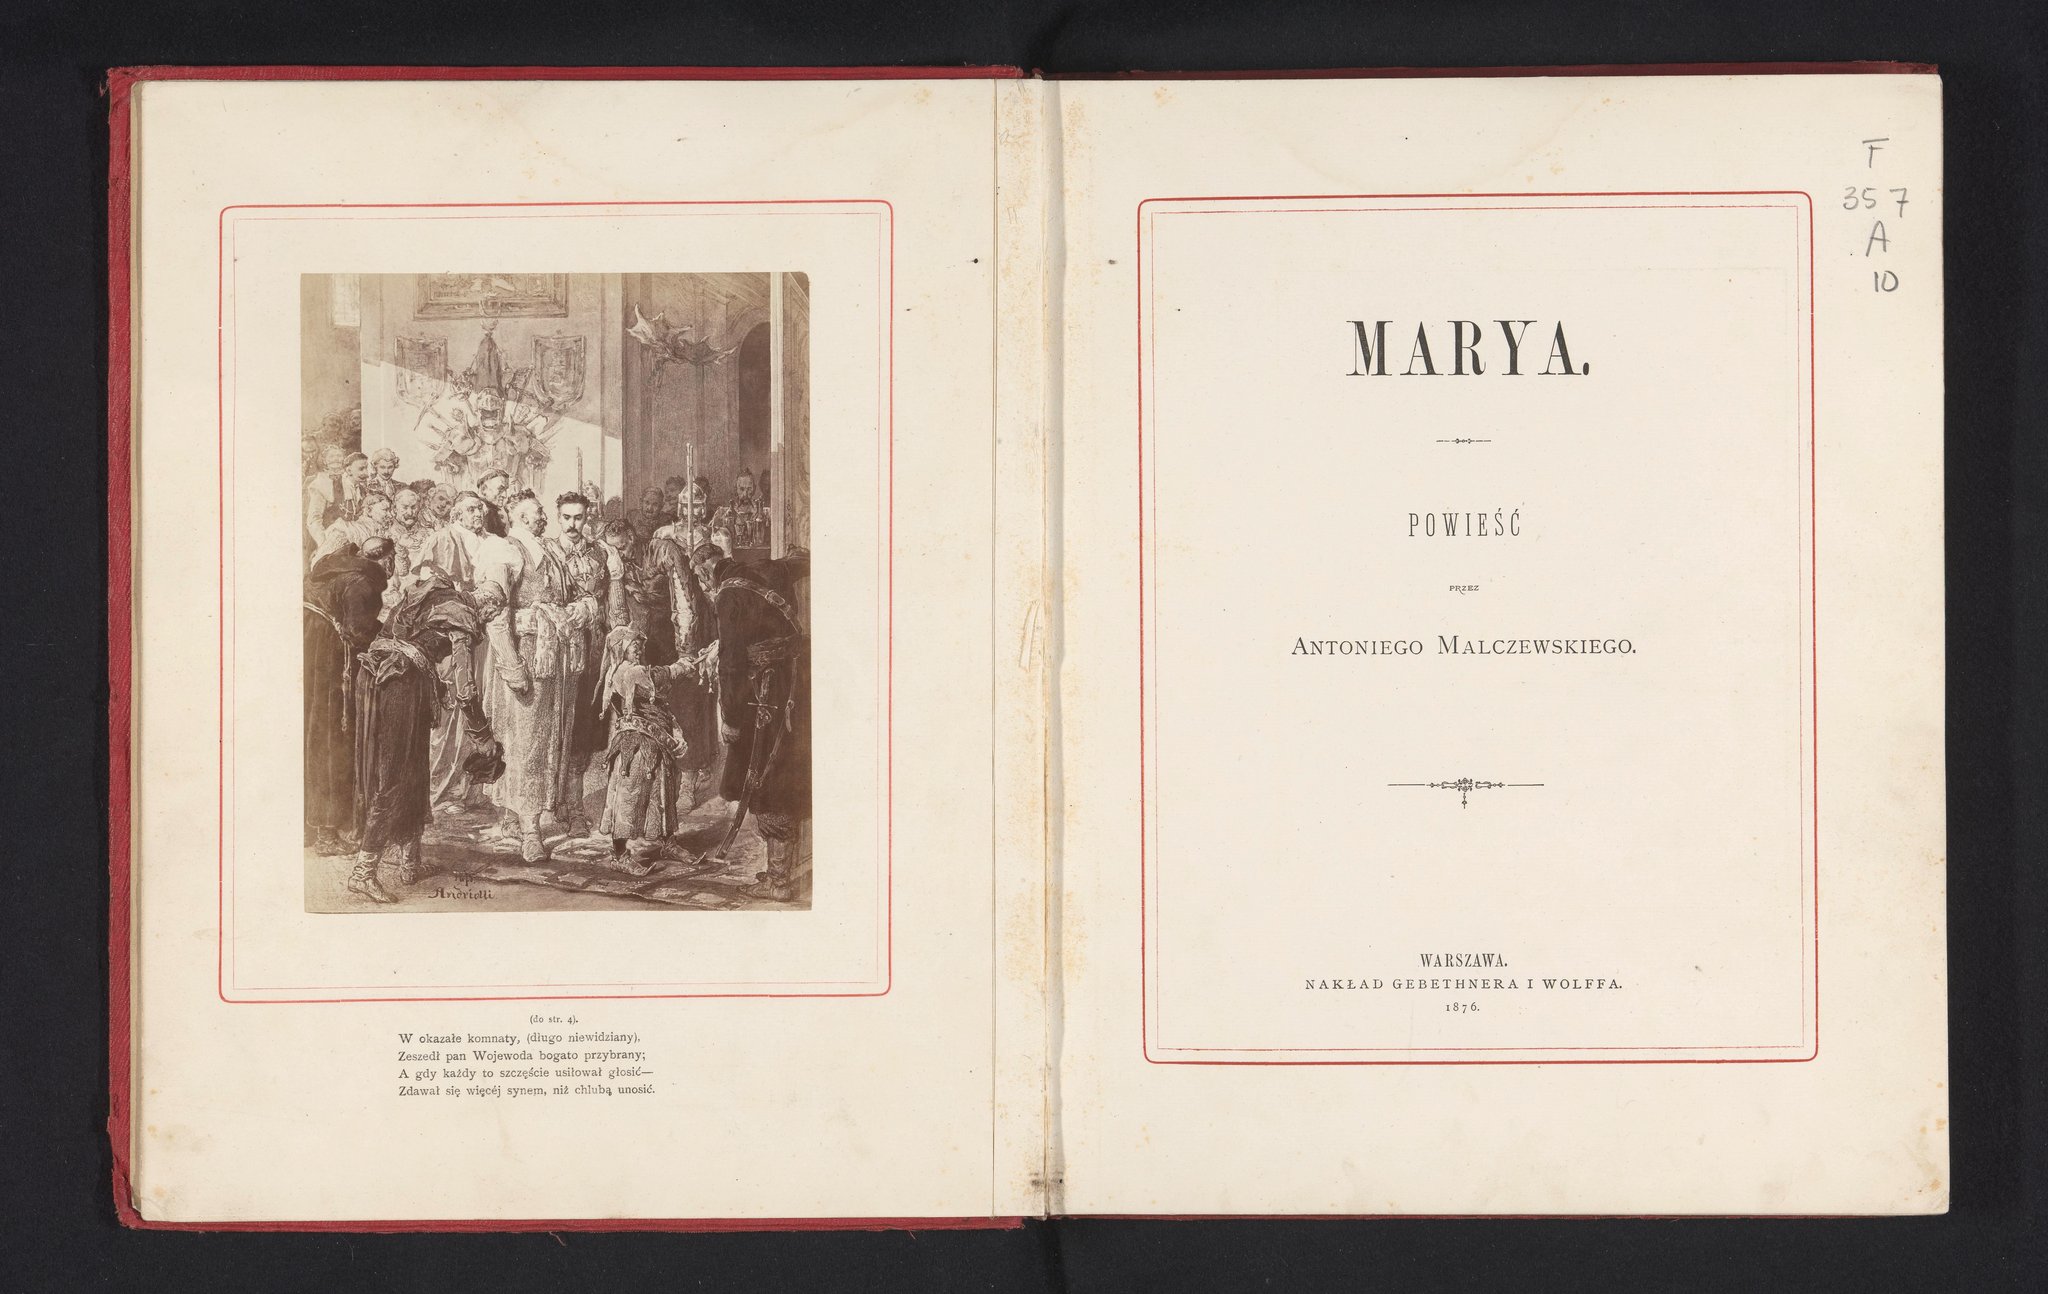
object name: photograph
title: Fotoreproductie van een schilderij voorstellende een gouverneur in een ruimte met mannen en een nar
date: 1866-1876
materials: photographic support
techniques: albumen print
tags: court jester, court fool, interior of the house, governor, etc. of province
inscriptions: inscription: ‘W okazałe komnaty, (Dlugo niewidziany) zszedł pan Wojewoda bogato przybrany; a gdy każdy to szczęscie usilowal glosic- zdawał sie więcéj synem, niż chubą unosić.’